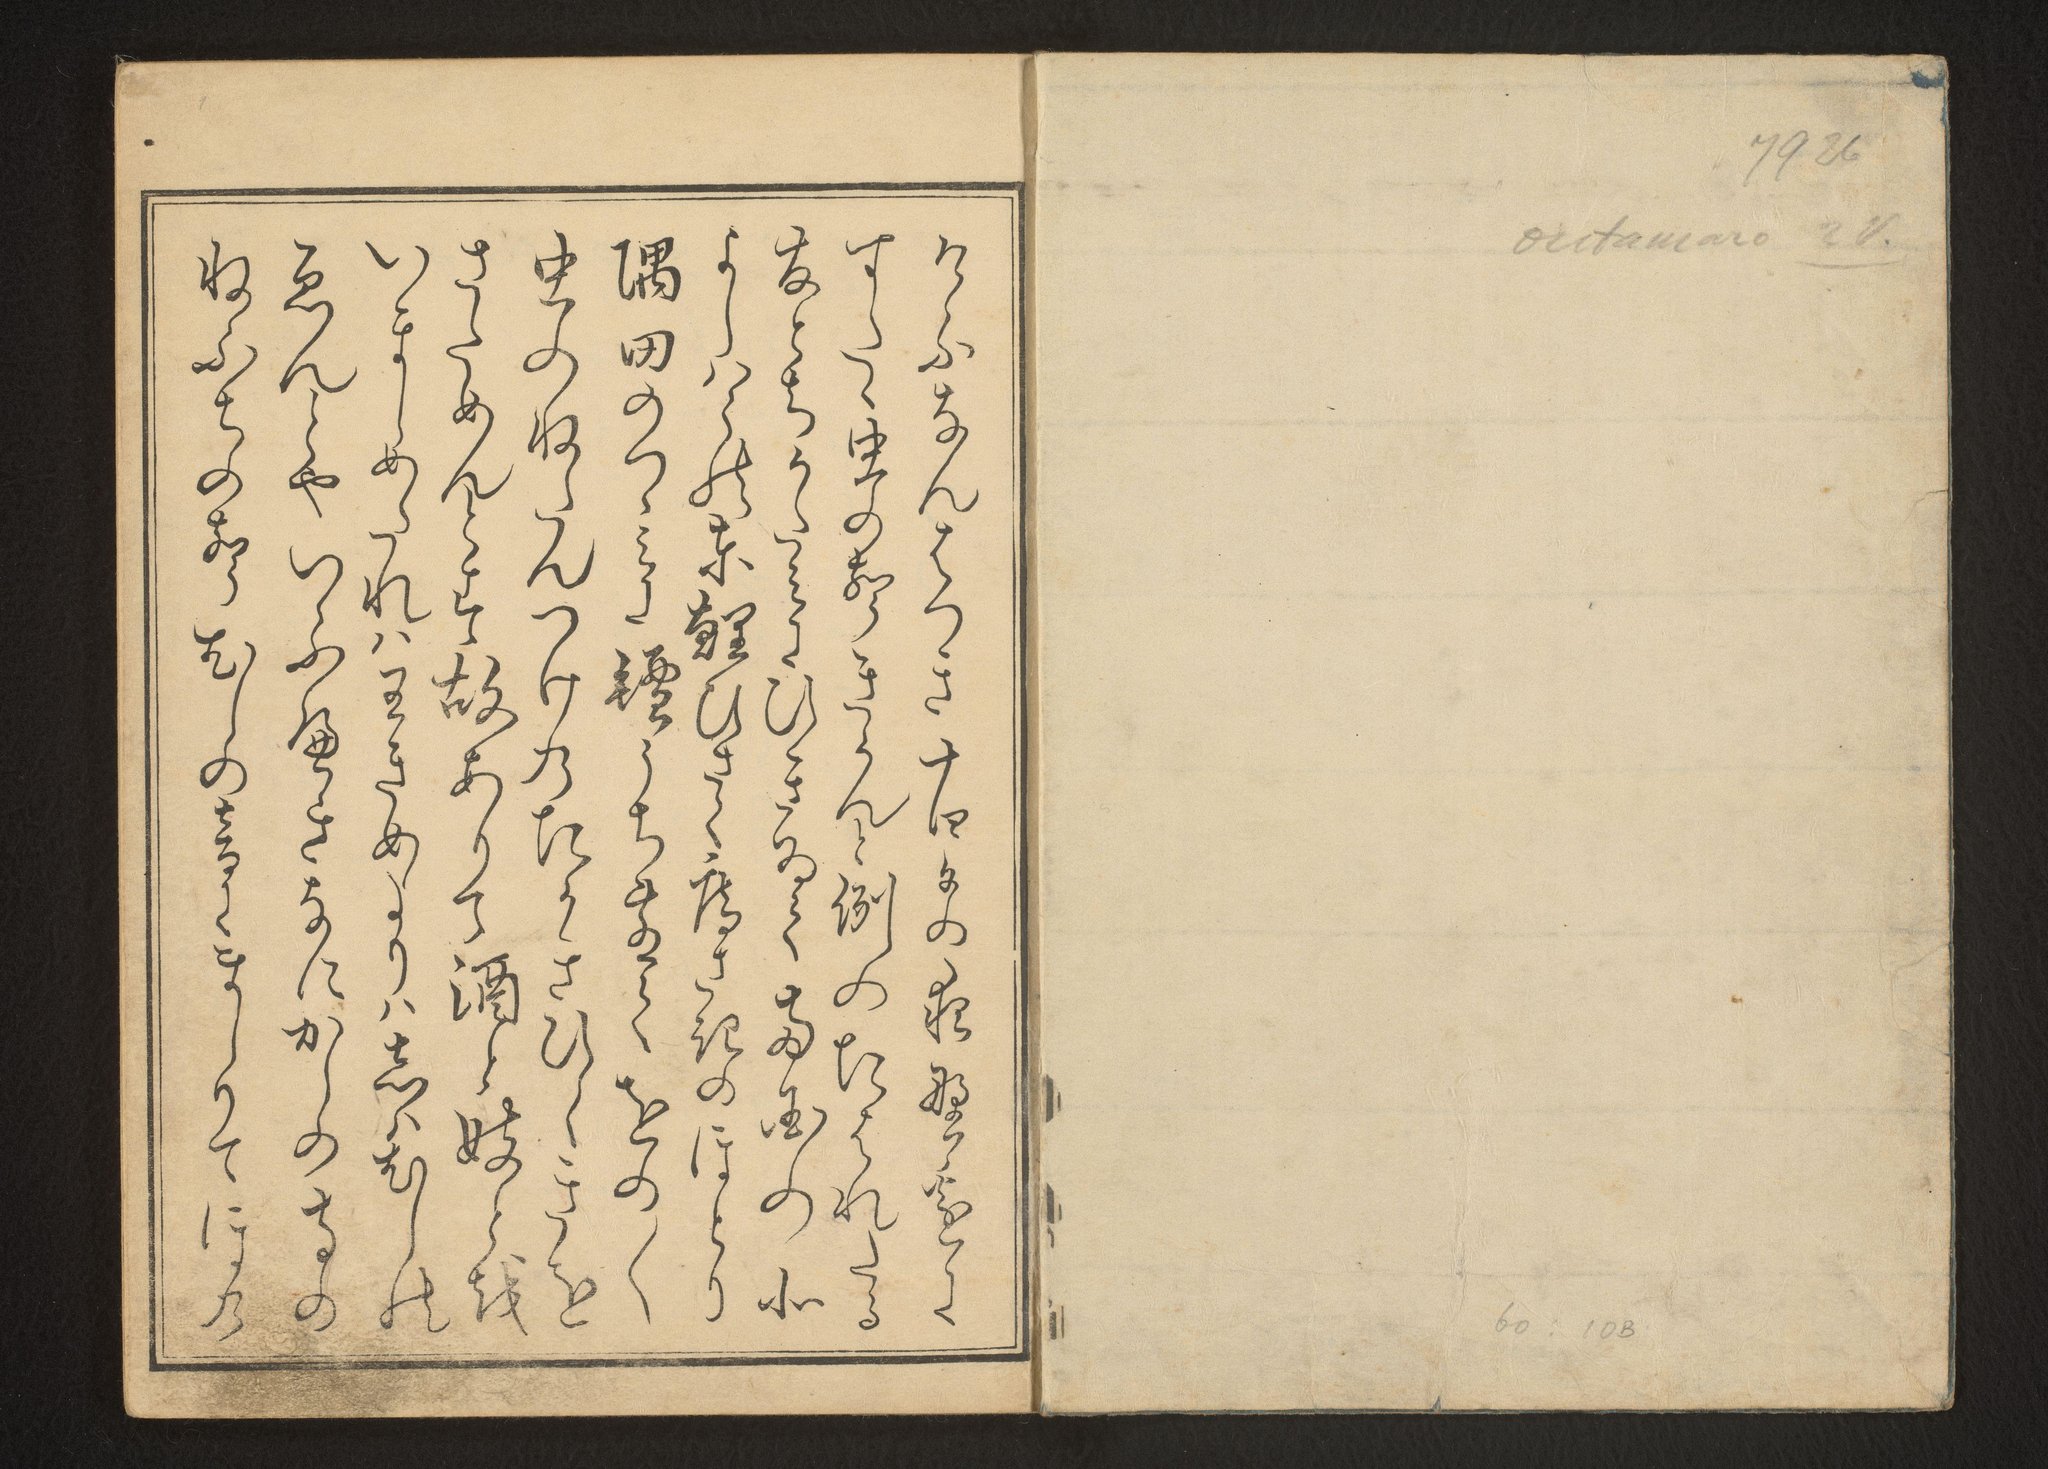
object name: page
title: Preface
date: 1788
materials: paper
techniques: woodcut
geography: edo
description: Pagina 1a in deel één van het Insectenboek van Utamaro.